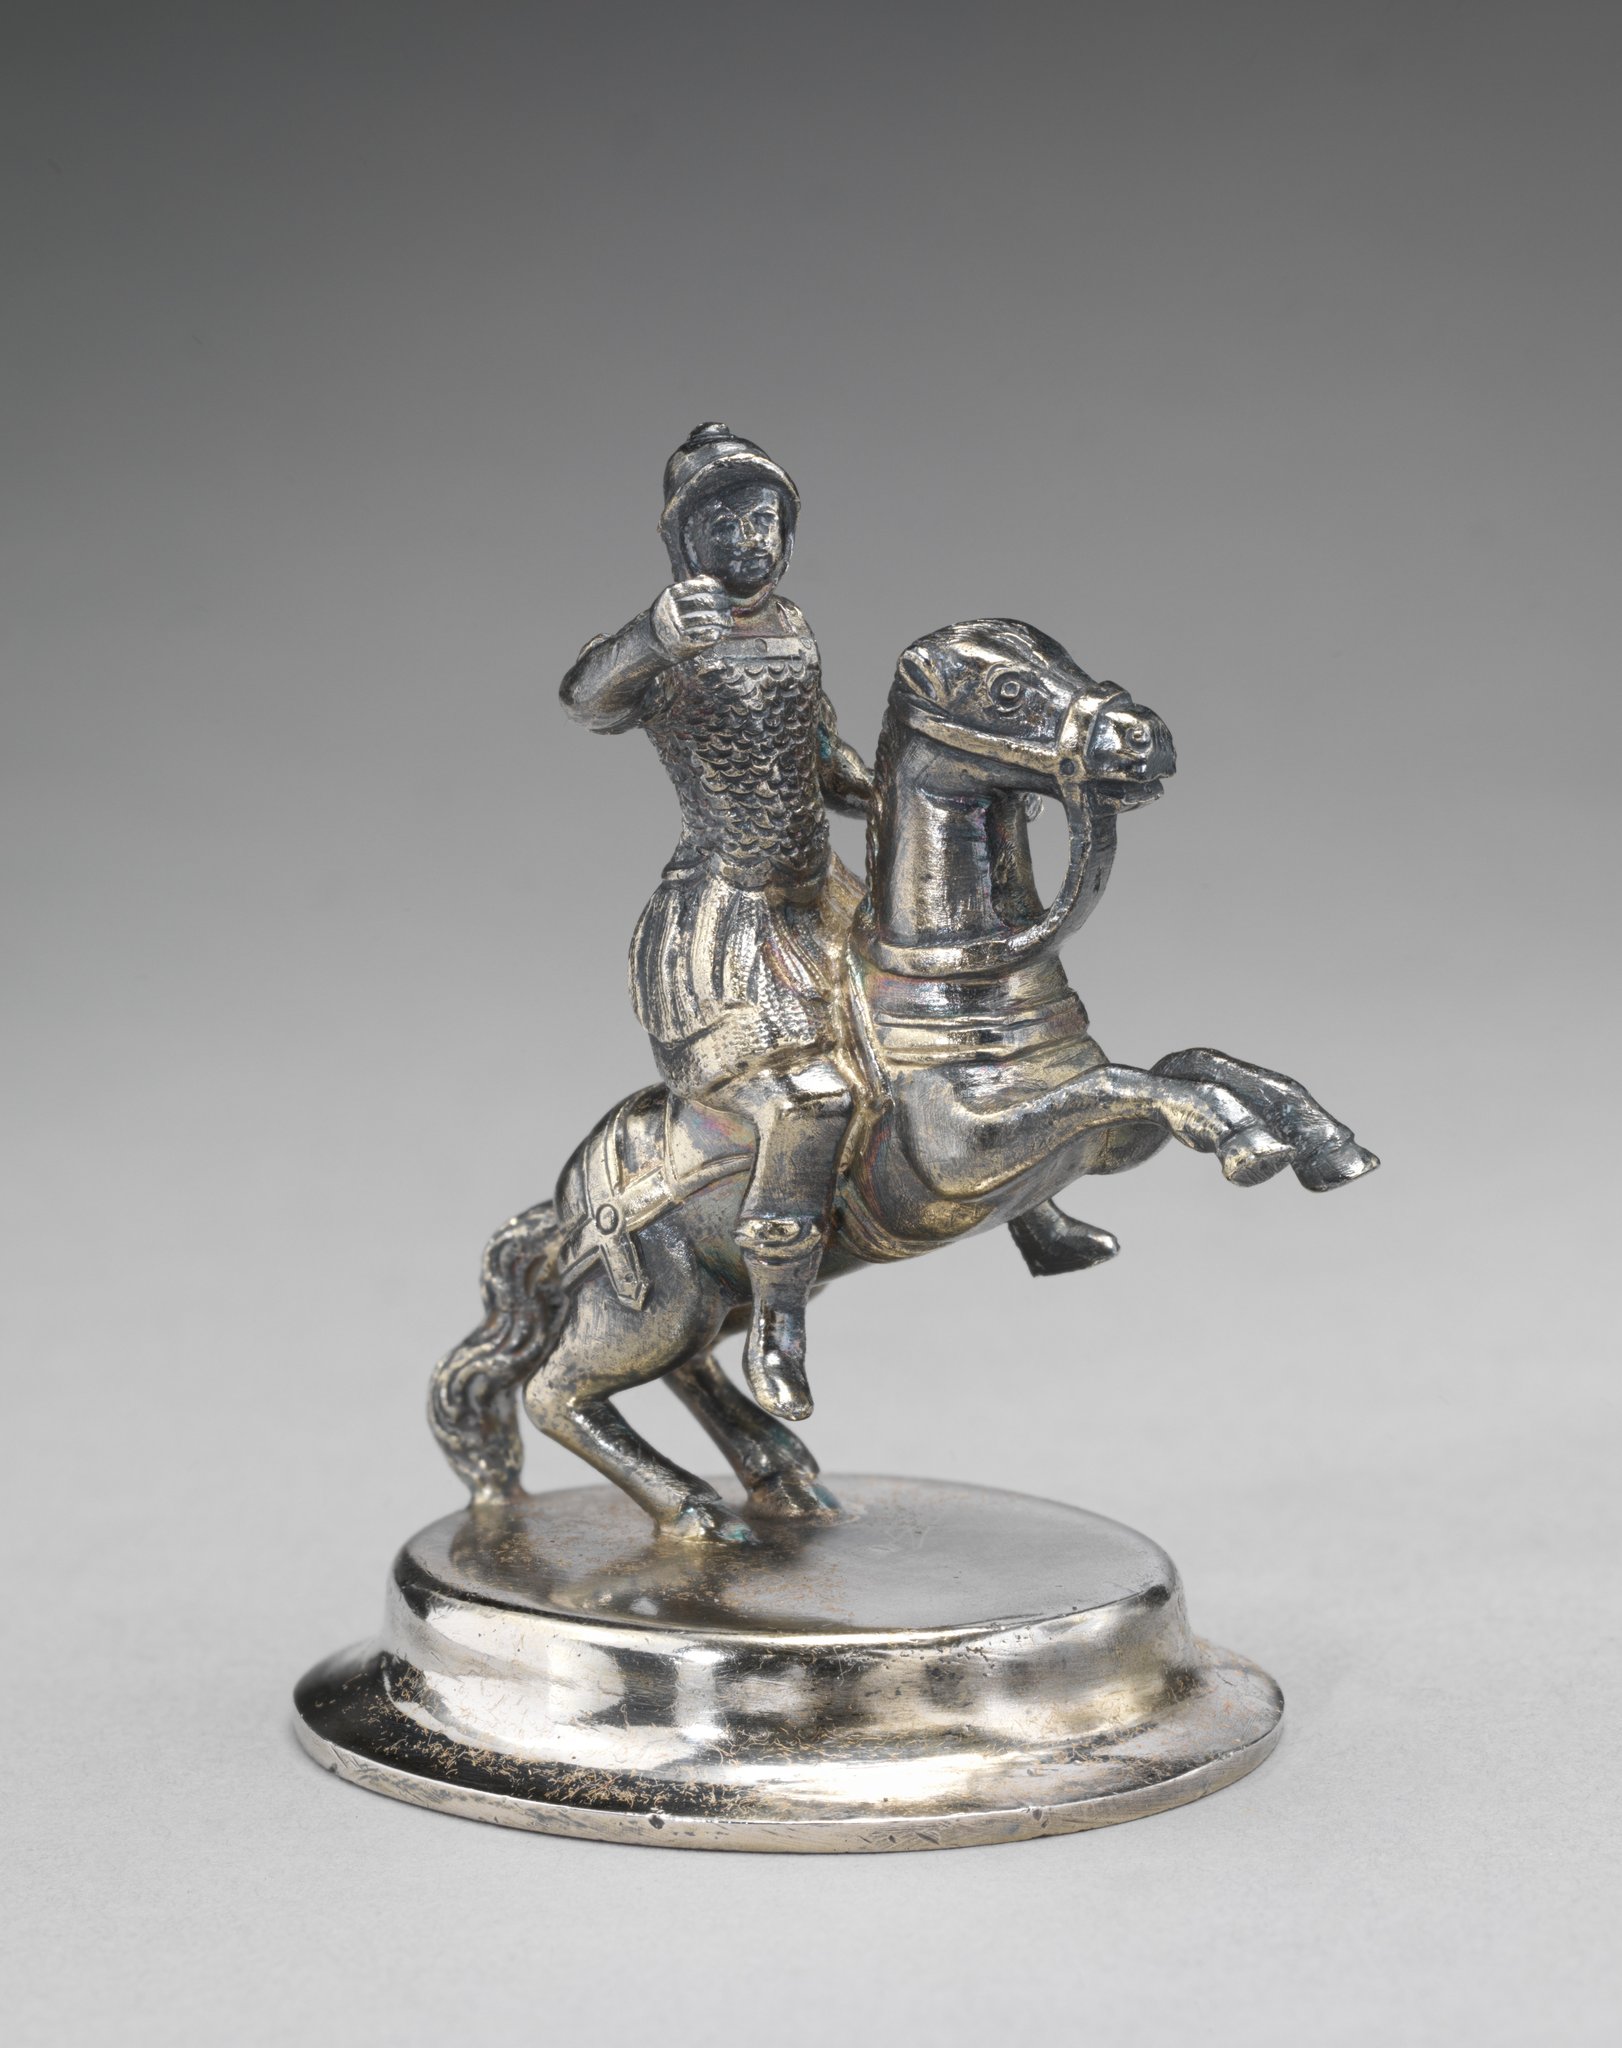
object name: chessman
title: Chessman (Knight)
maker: elkington & co.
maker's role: manufacturer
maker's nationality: british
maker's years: 1829-1963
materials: silver gilt